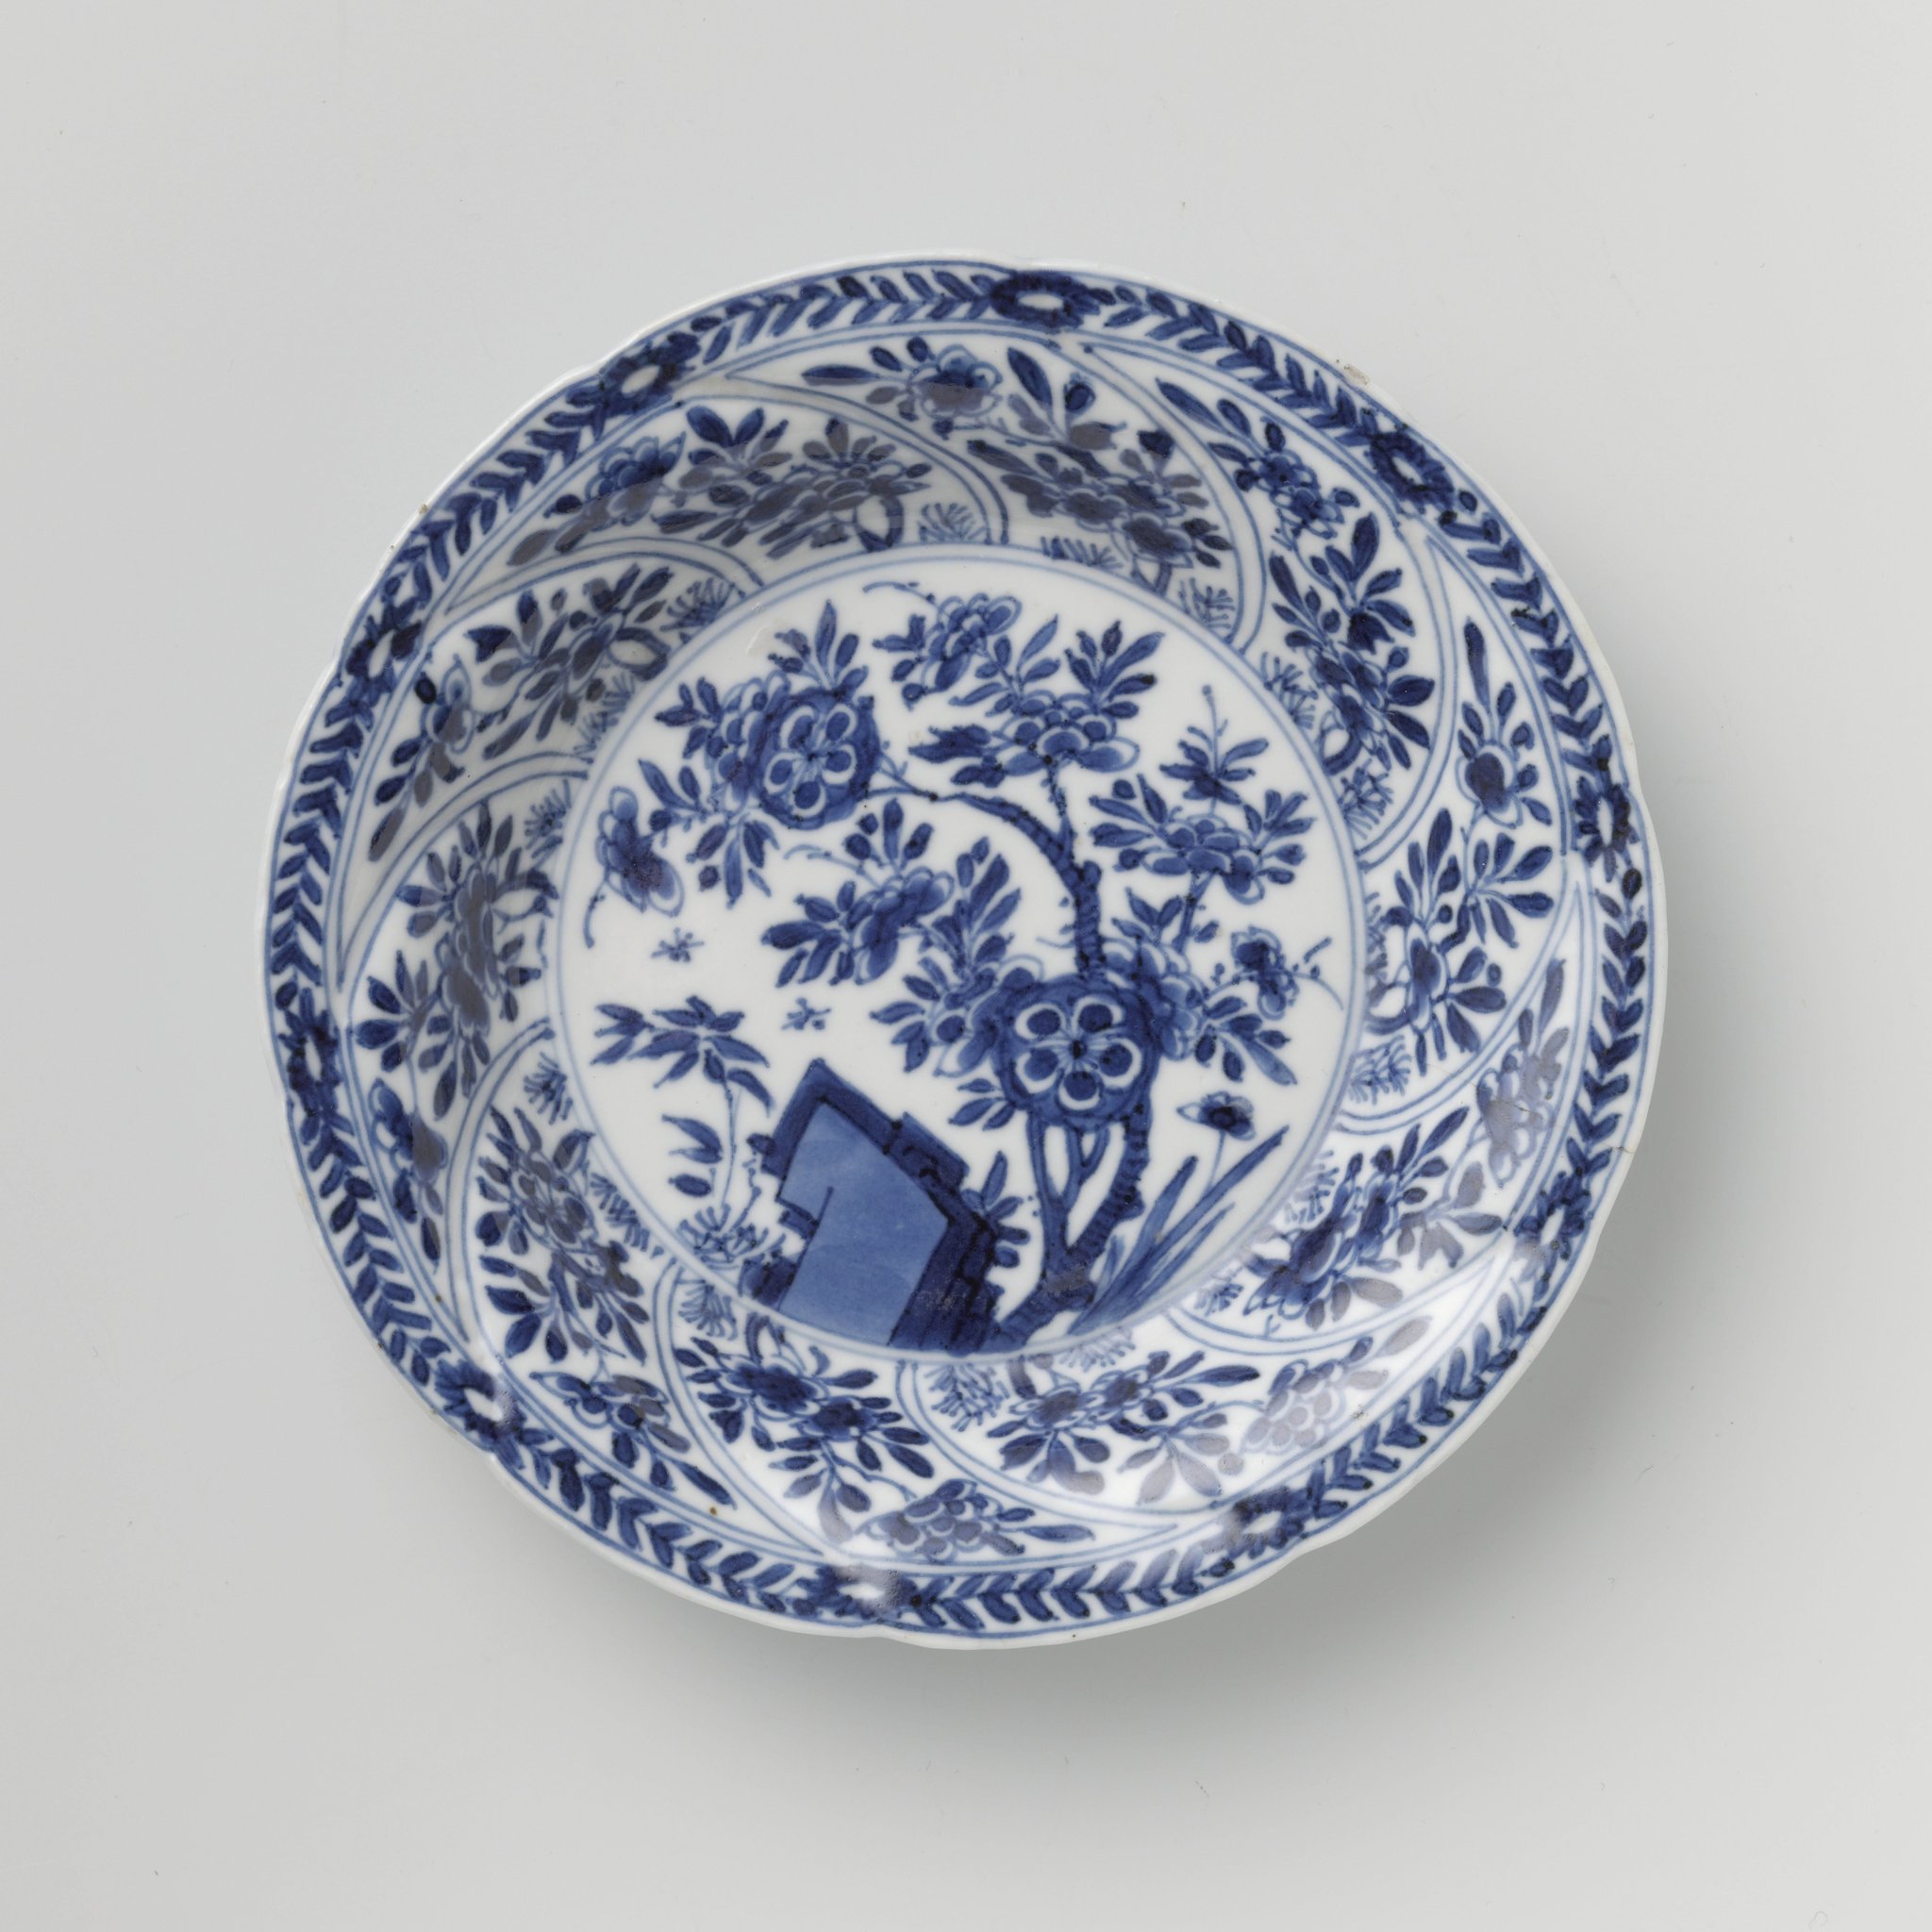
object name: platter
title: Saucer with twisted panels and flower sprays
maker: Anonymous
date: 1680-1720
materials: cobalt, glaze, paint, porcelain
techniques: firing, forming, turning, vitrification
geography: china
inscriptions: mark: ‘福 Fú’